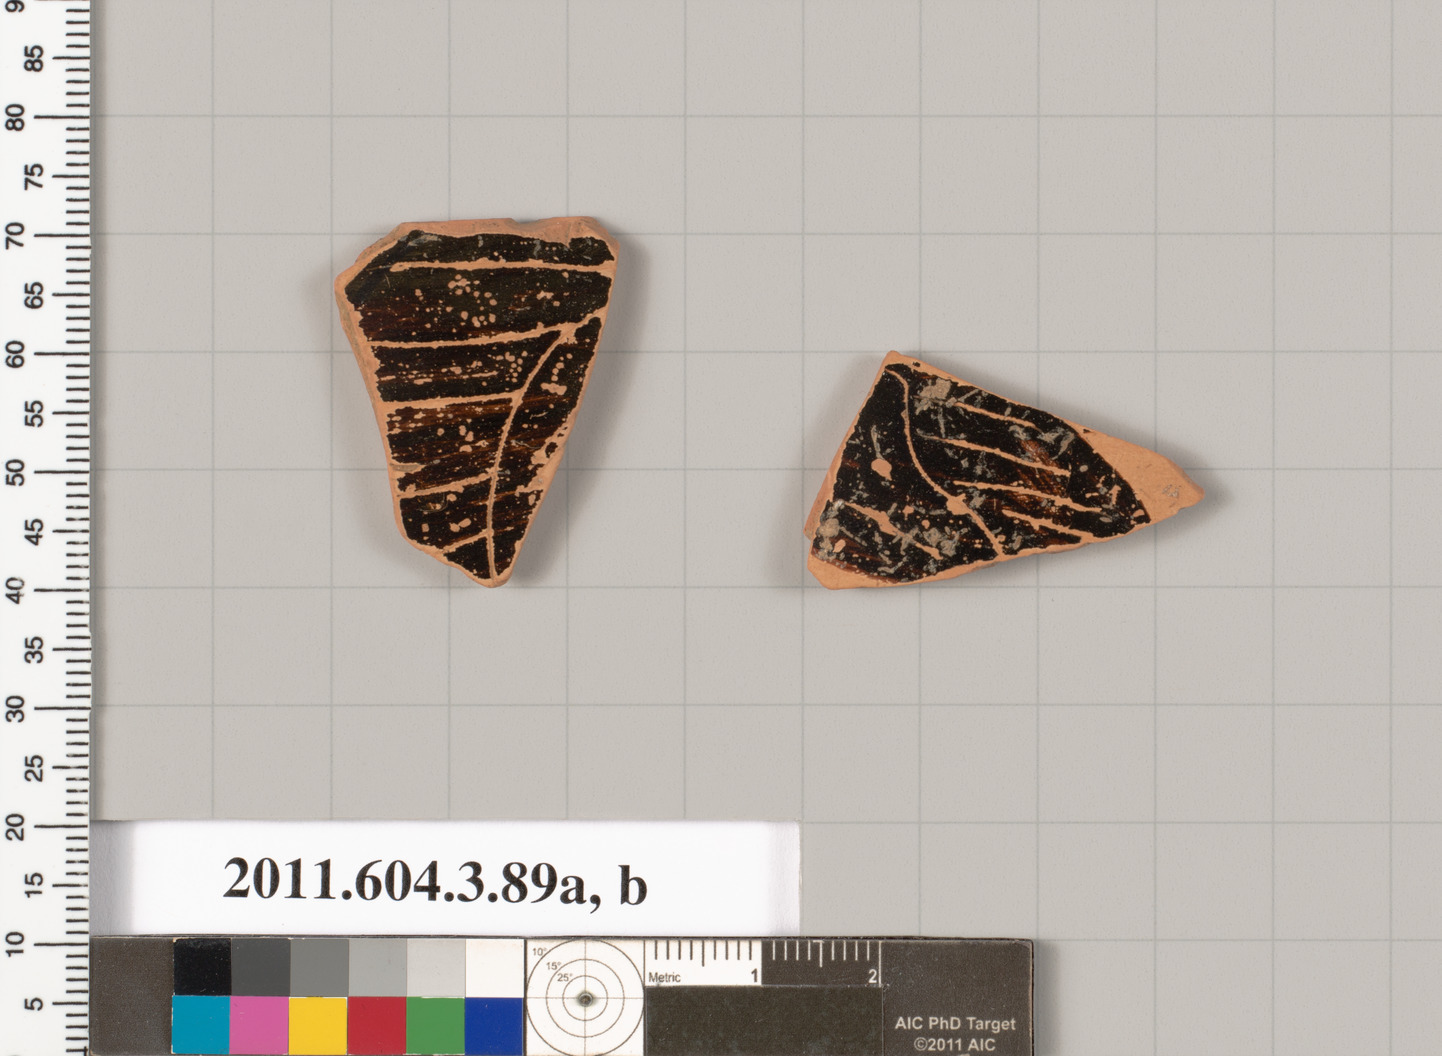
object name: amphora fragment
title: Terracotta fragments of an amphora (jar)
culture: greek, attic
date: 500-468 BCE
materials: terracotta